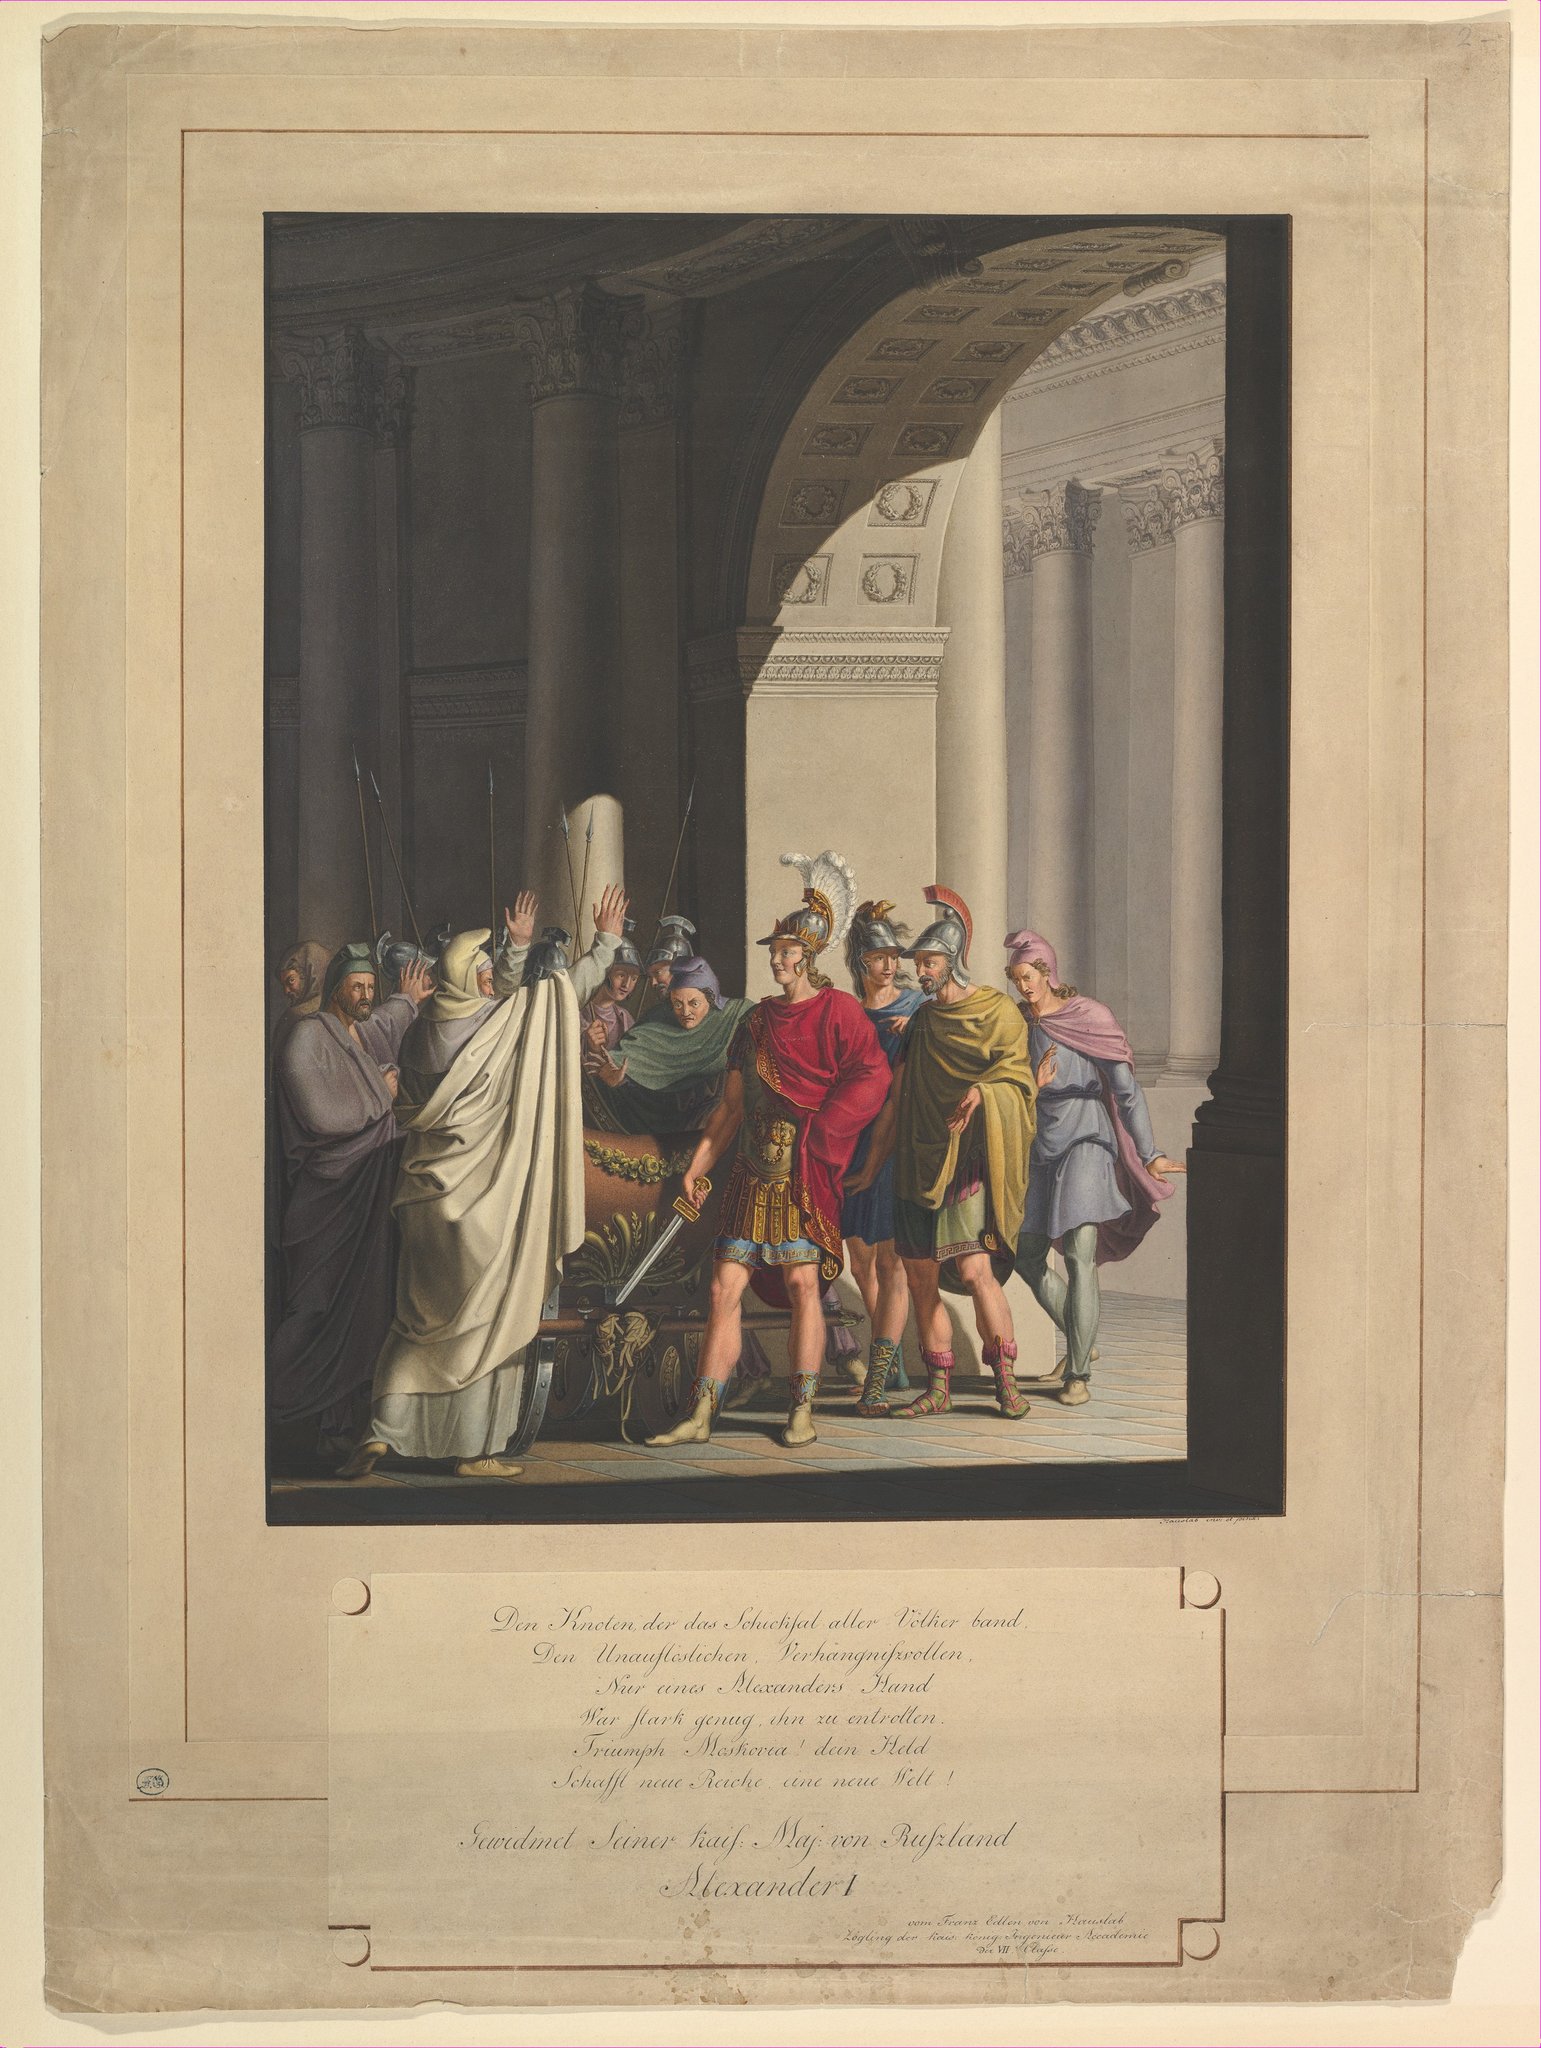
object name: drawing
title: Scene from the Life of Alexander I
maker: franz von hauslab the younger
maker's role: artist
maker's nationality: austrian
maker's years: 1798-1883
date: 1801-1900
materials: ink, watercolor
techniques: brush, pen, wash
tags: soldiers,weapons,spears,men